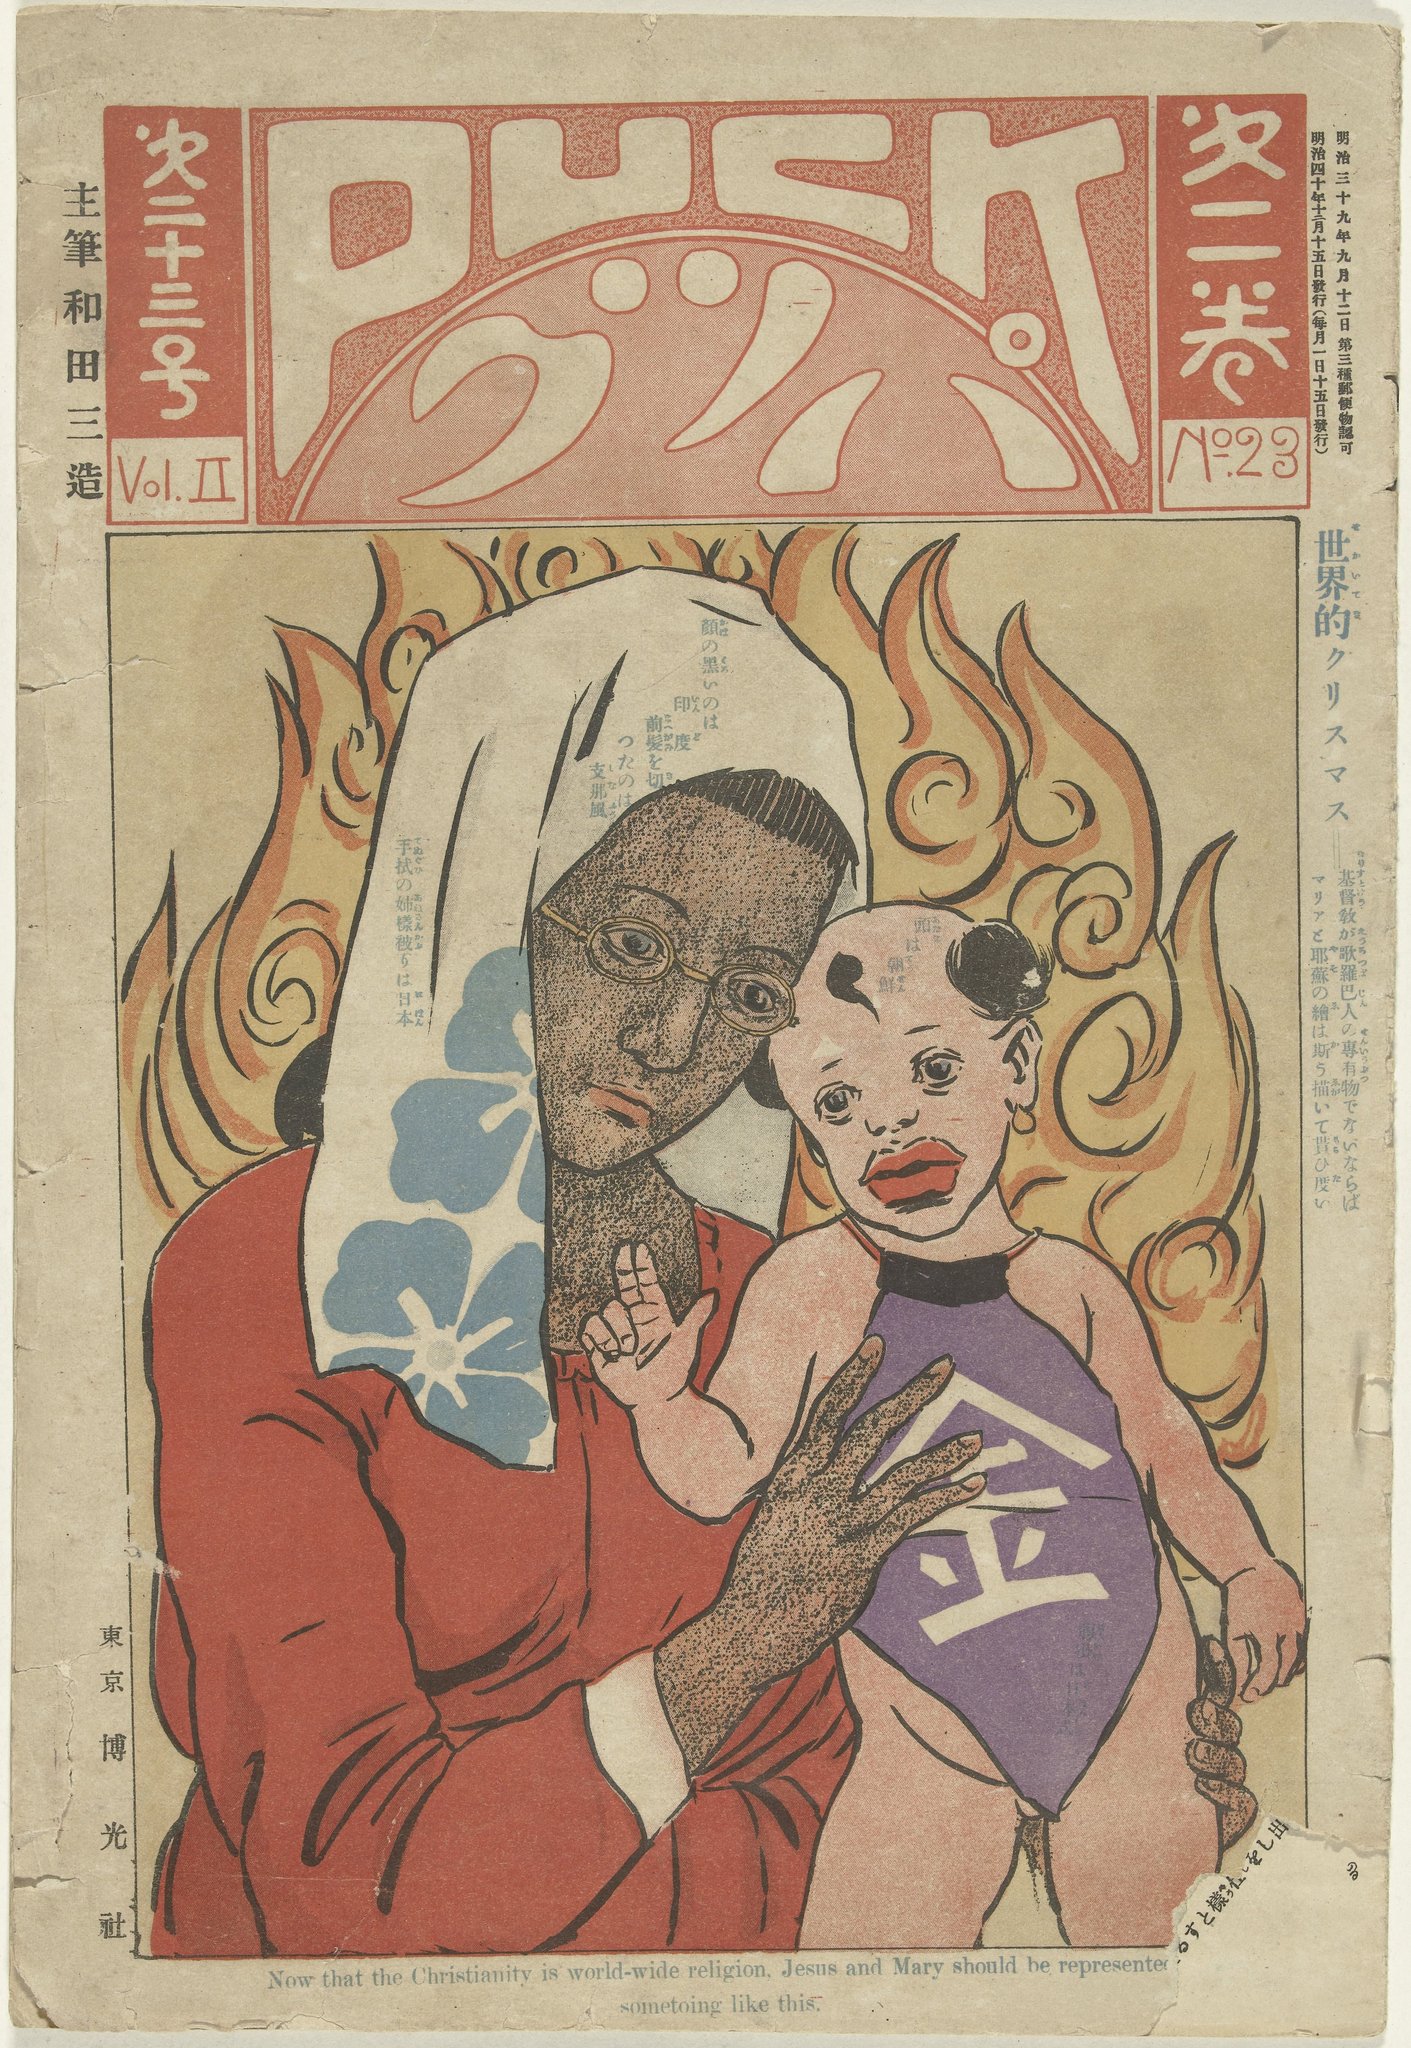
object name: book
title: Puck - December 1907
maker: sanzô wada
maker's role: painter, print maker, publisher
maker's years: 1883-1967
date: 1907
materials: paper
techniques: printing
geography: tokyo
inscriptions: date